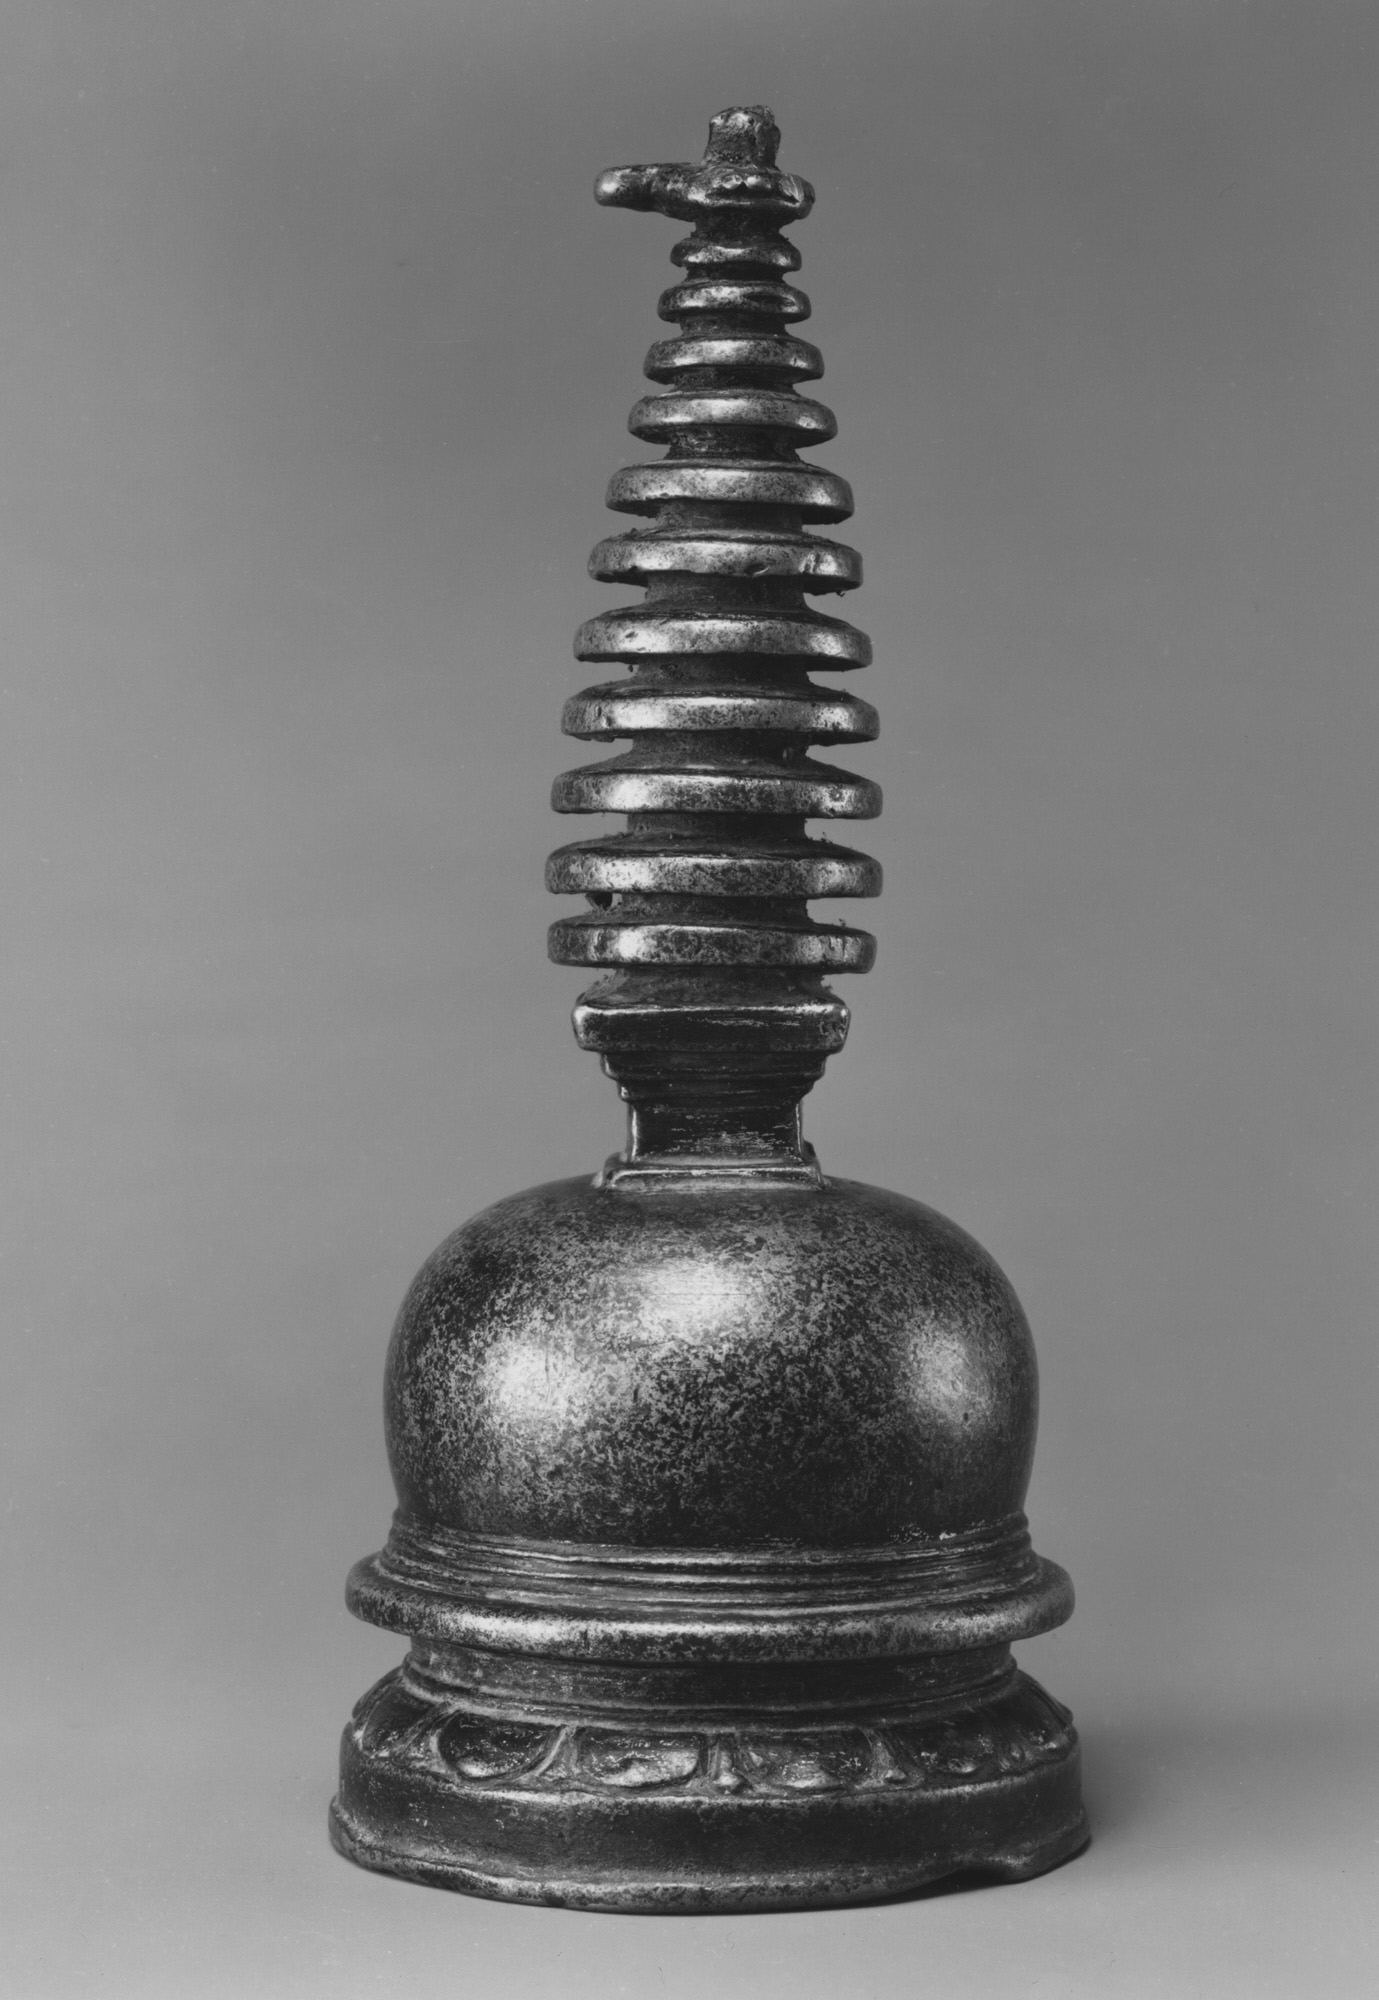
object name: stupa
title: Model of a Stupa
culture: nepali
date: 901-1400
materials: copper alloy, gilt